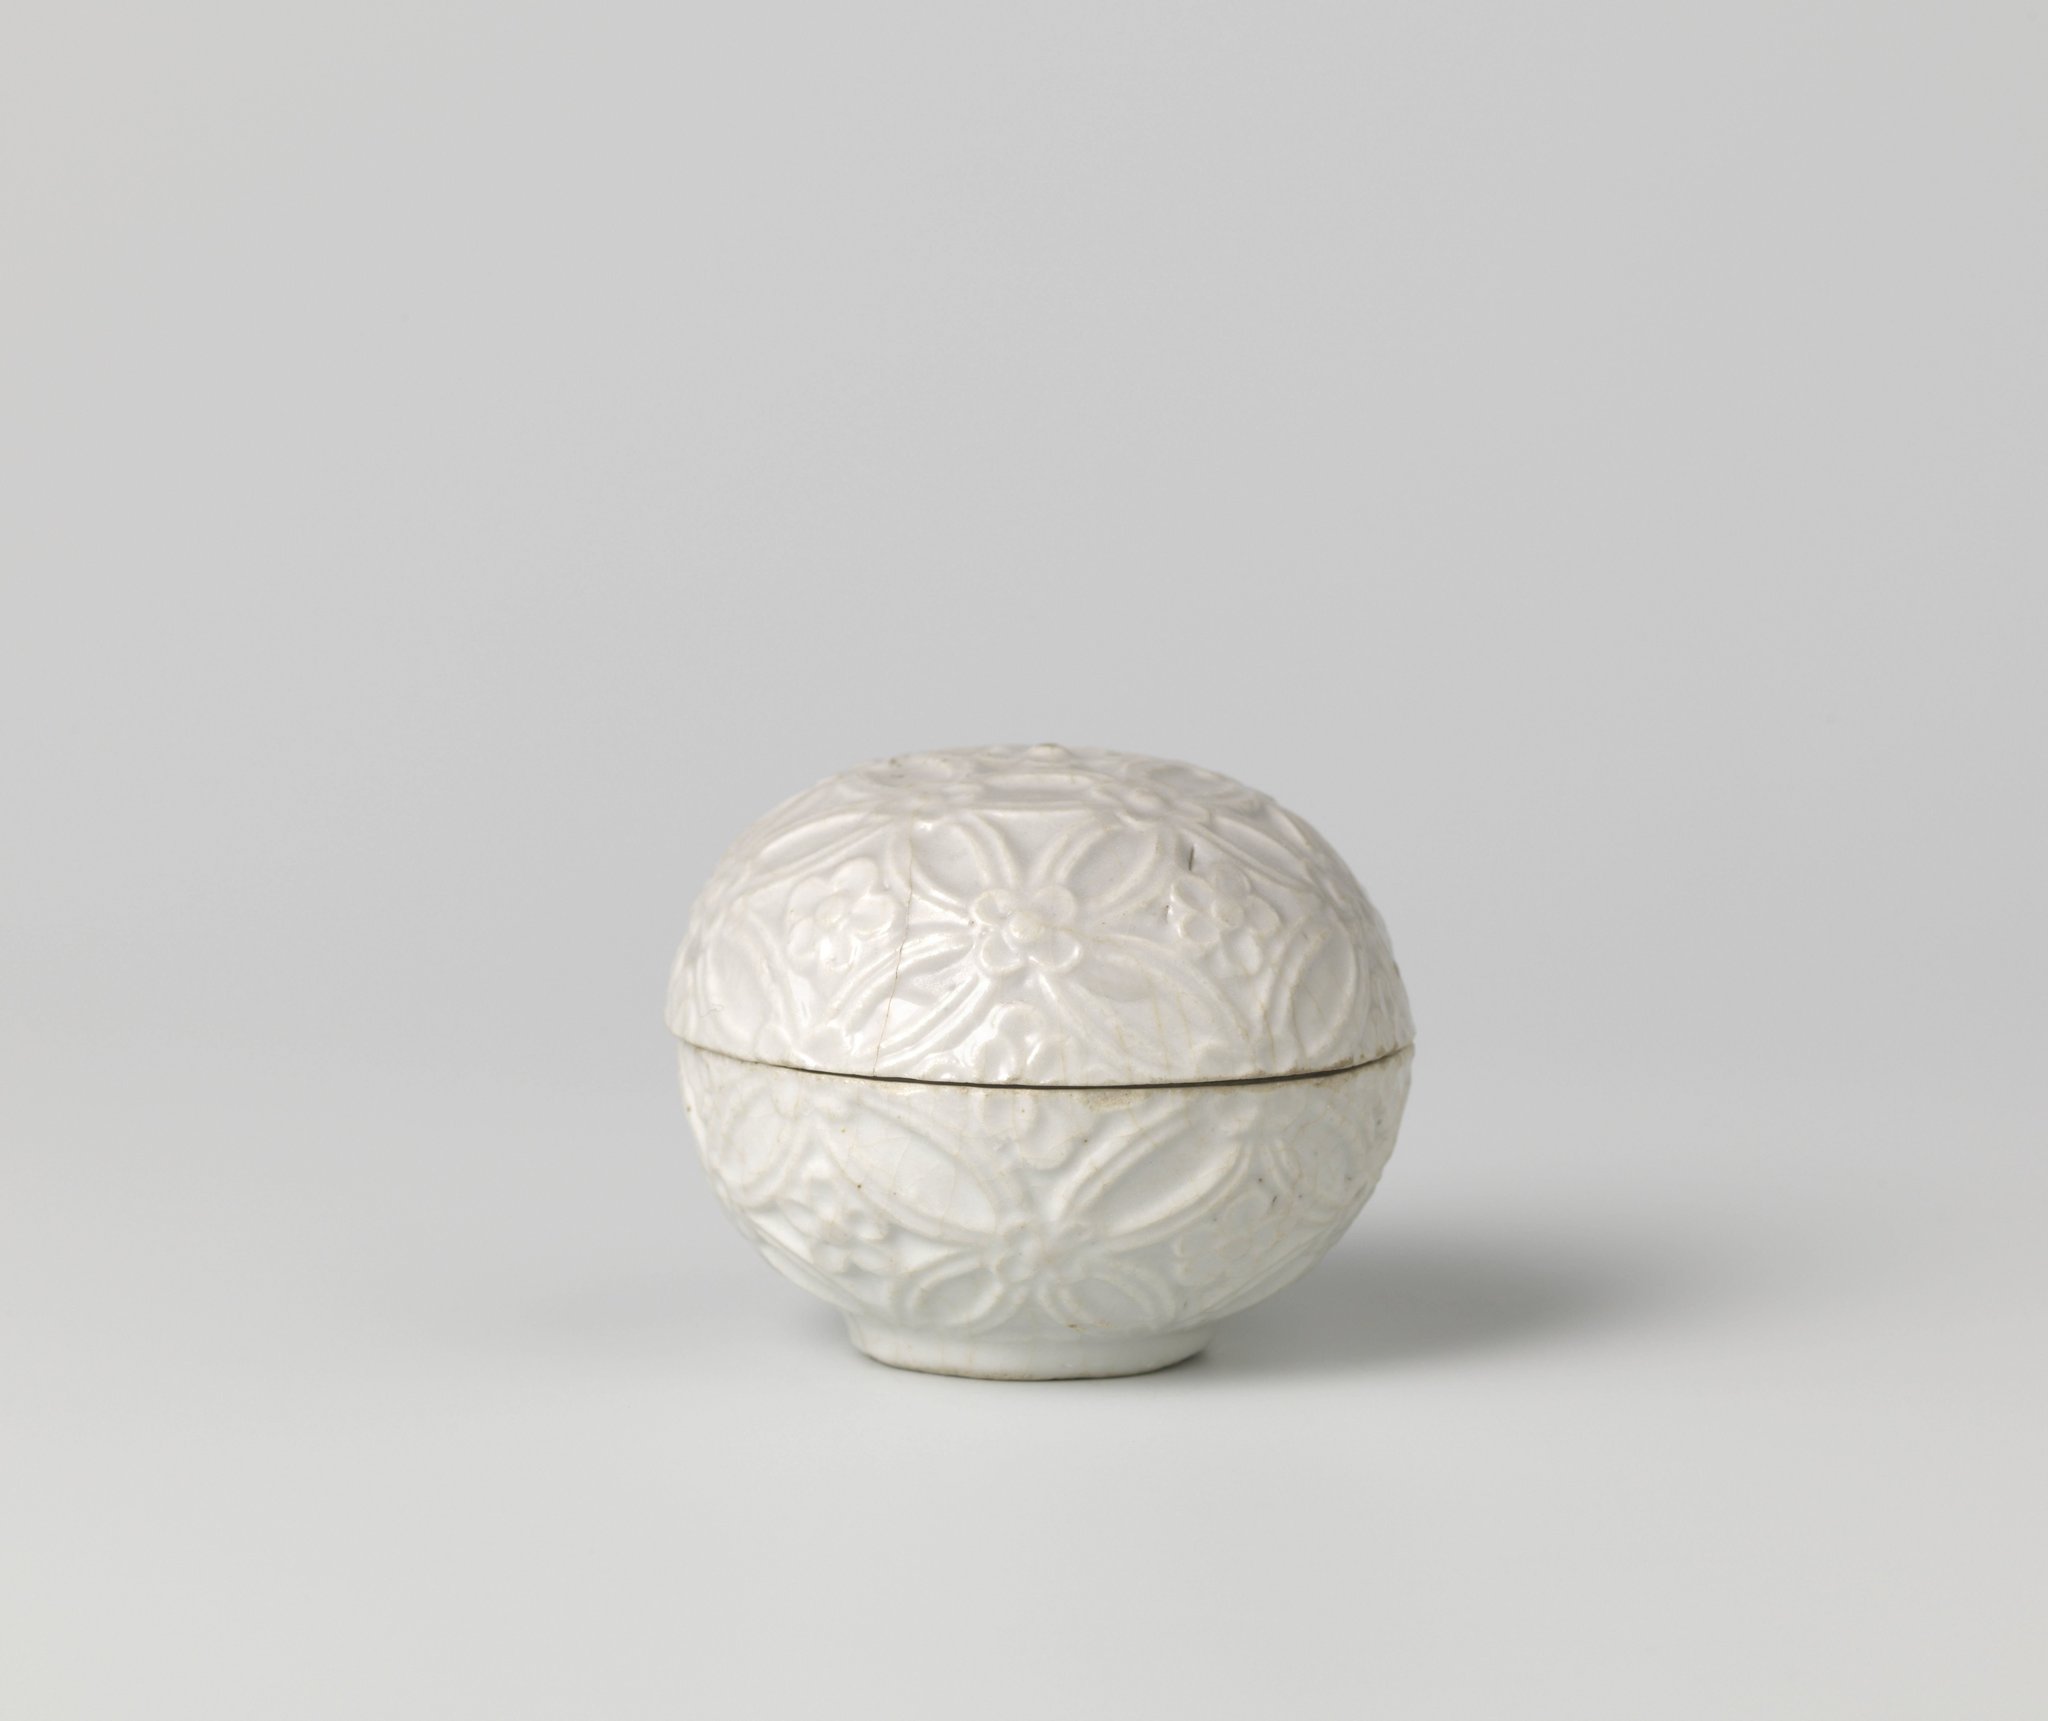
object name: box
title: Round-bodied box with continuous flower motif in relief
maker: Anonymous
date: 1300-1500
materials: glaze, porcelain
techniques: firing, relief, turning, vitrification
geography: china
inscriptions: label: ‘van lier’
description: Deksel van bolvormige doos van porselein, bedekt met een grijs glazuur. Bedekt met een doorlopend bloemmotief in reliëf. Twee barsten in de deksel. Twee oude labels in de doos met 'van lier'. Ming porselein.